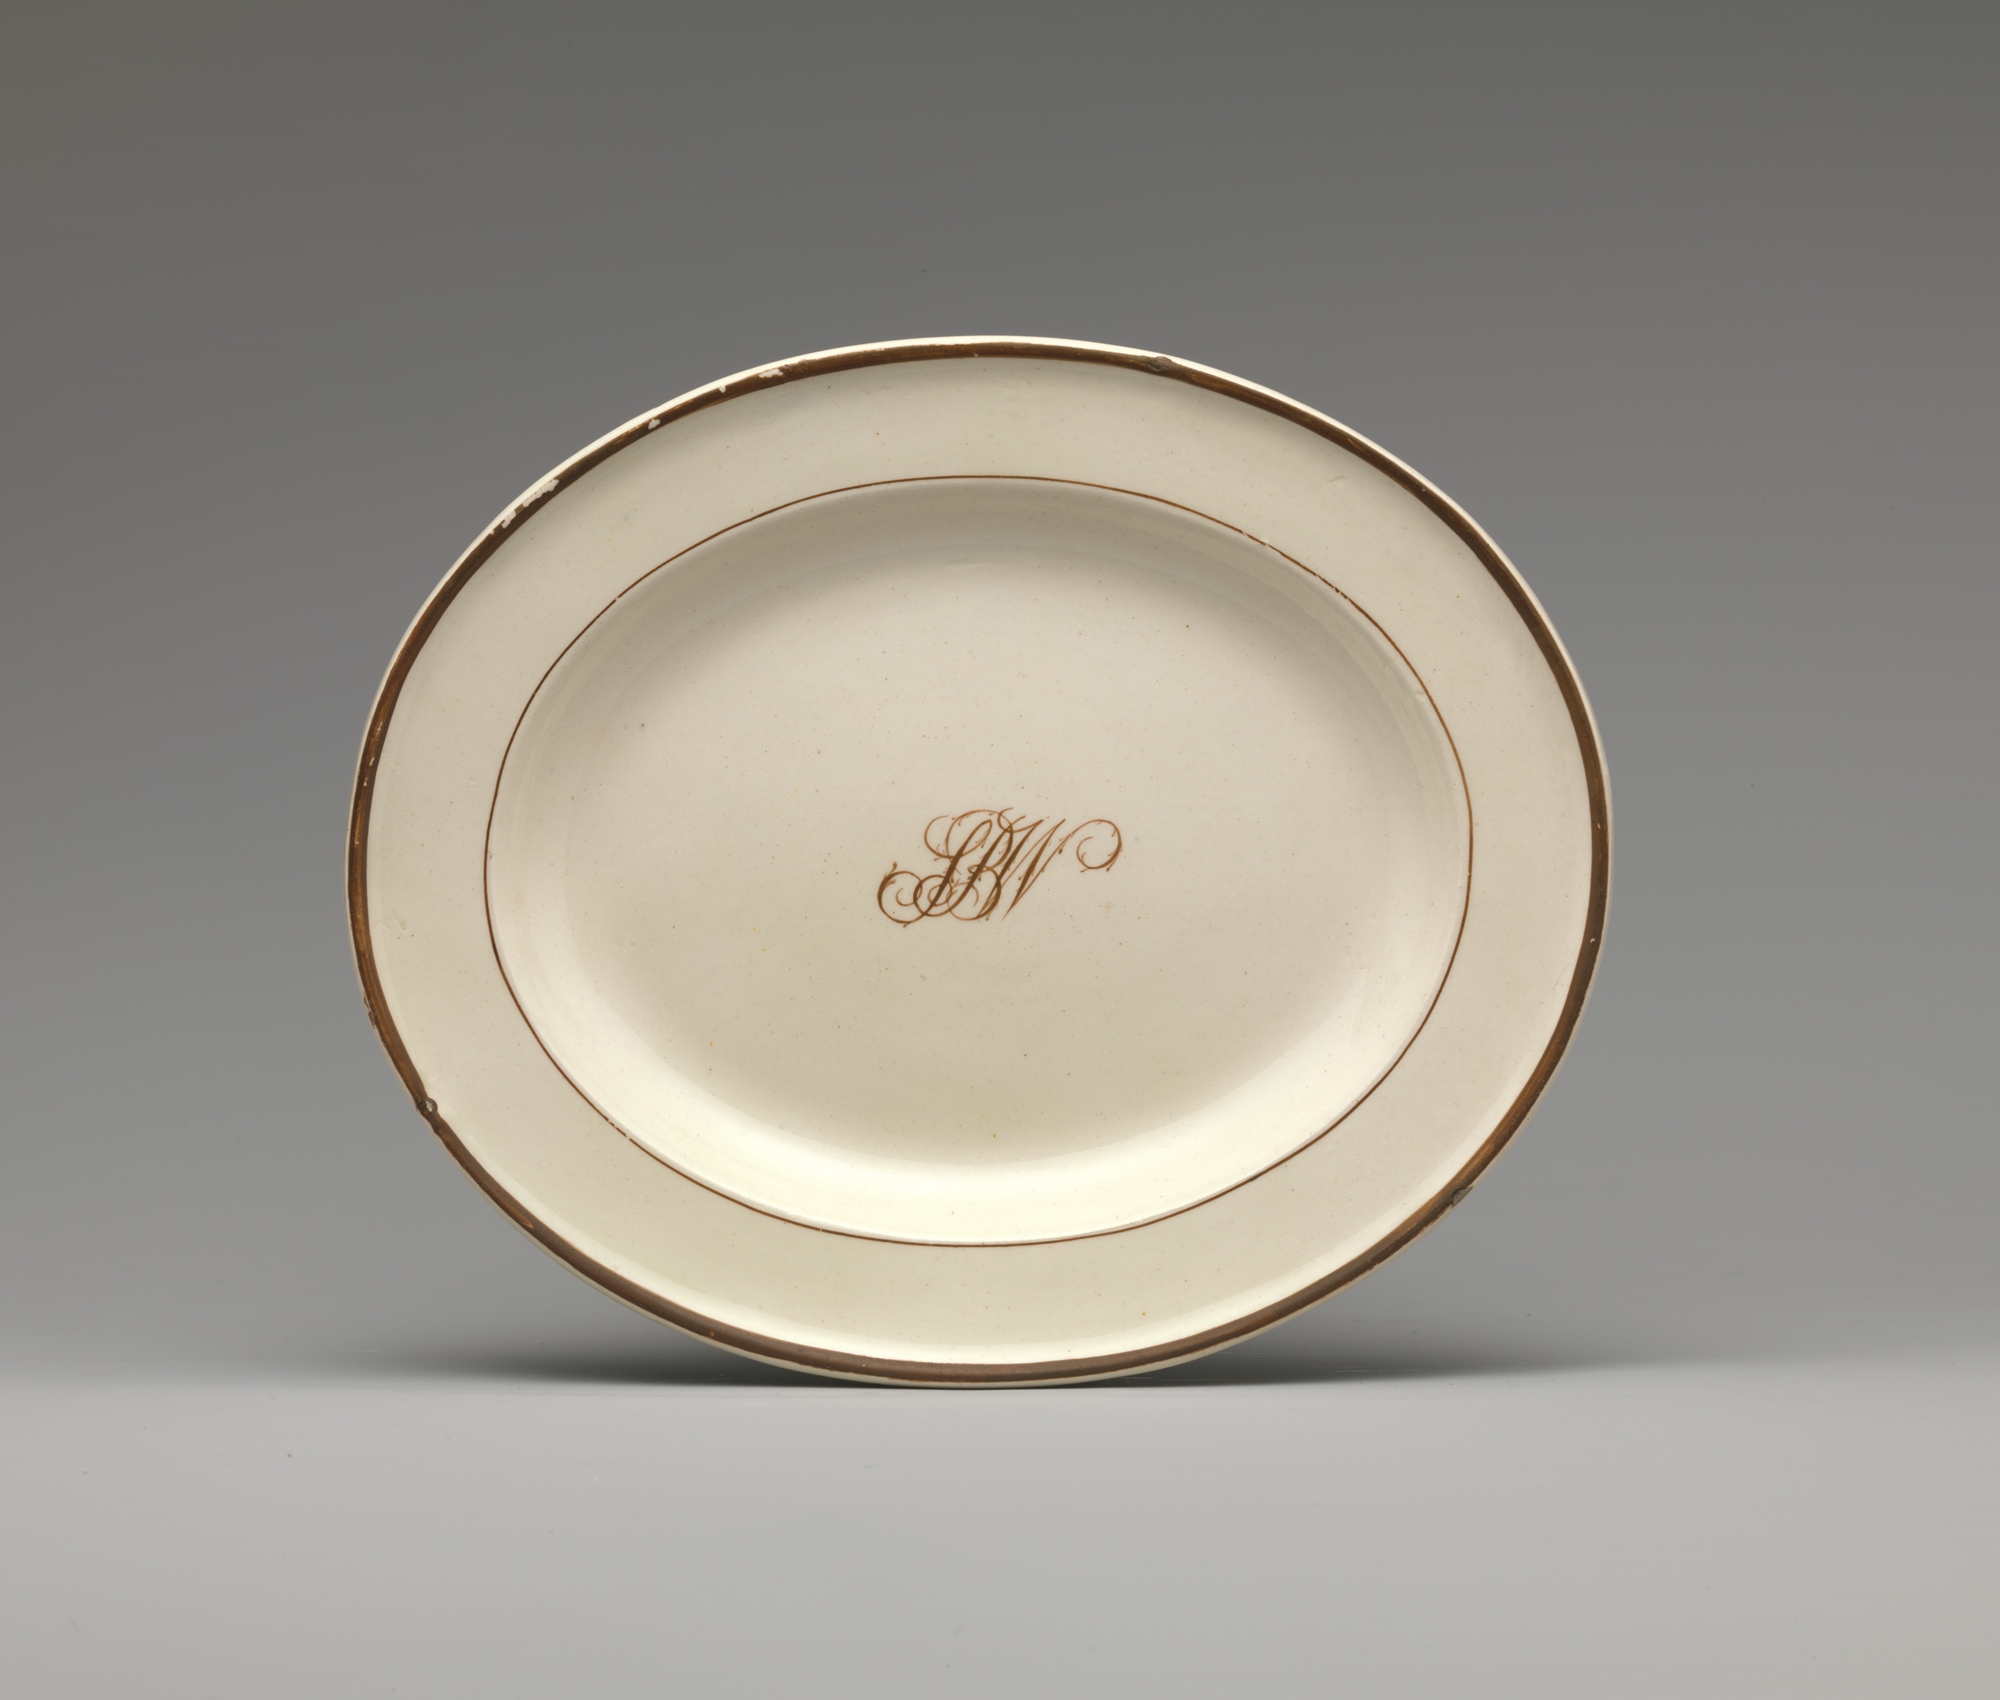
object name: dish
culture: british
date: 1750-1775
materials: earthenware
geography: england